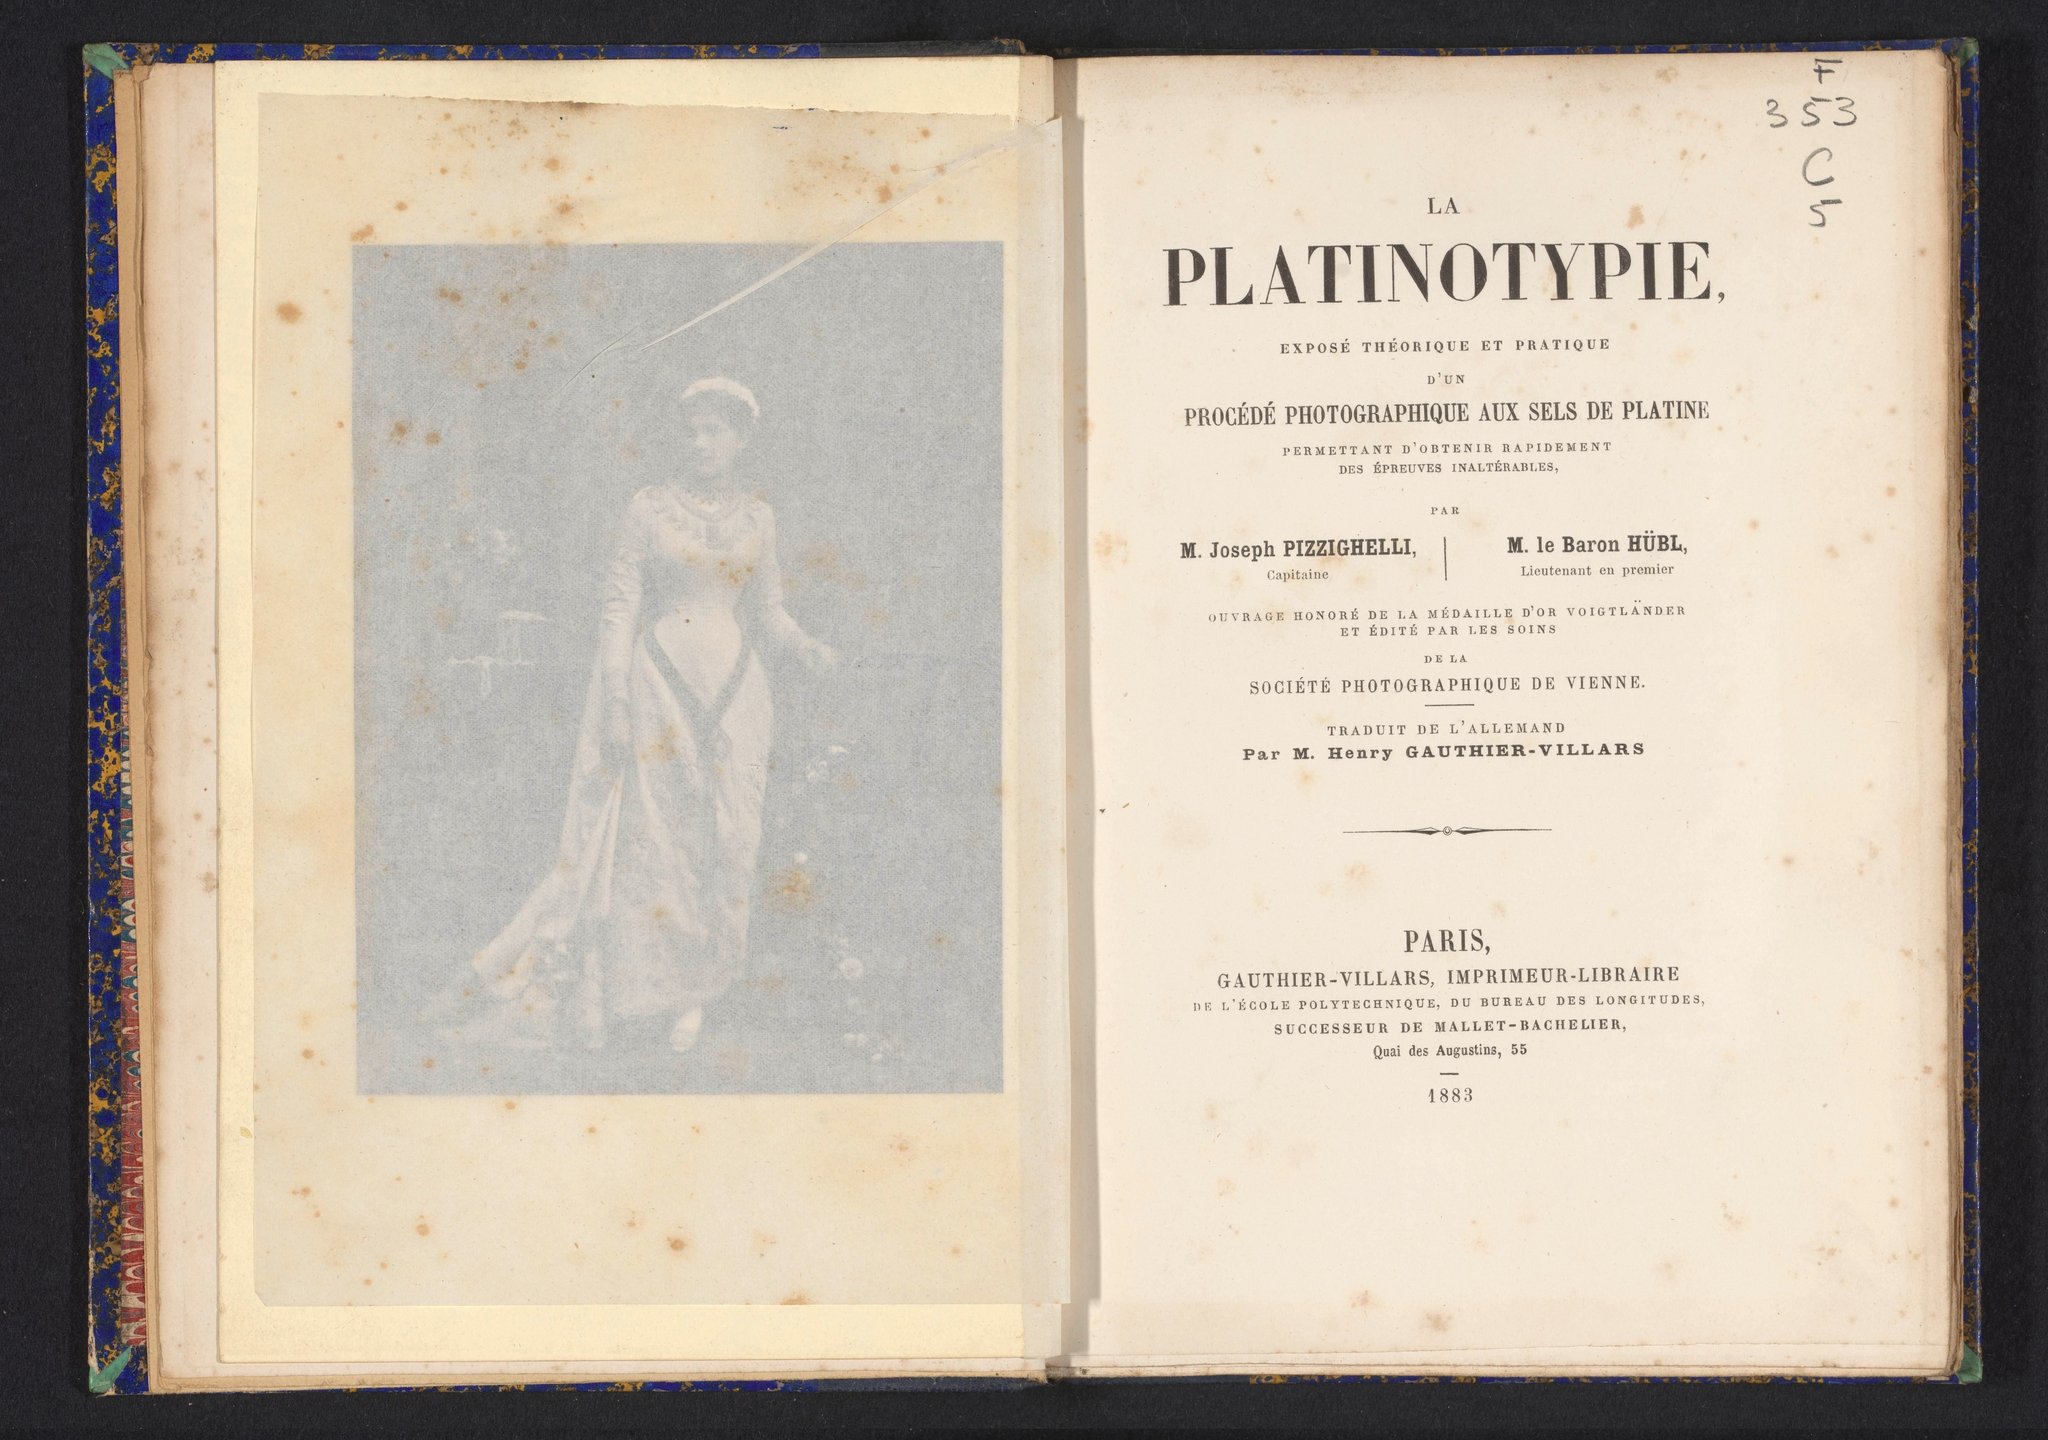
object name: book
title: La platinotypie, exposé théorique et pratique d'un procédé photographique aus sels de platine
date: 1883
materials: cardboard, linen, paper, photographic support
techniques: marbled paper, combed marbled paper, platinum process, printing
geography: paris